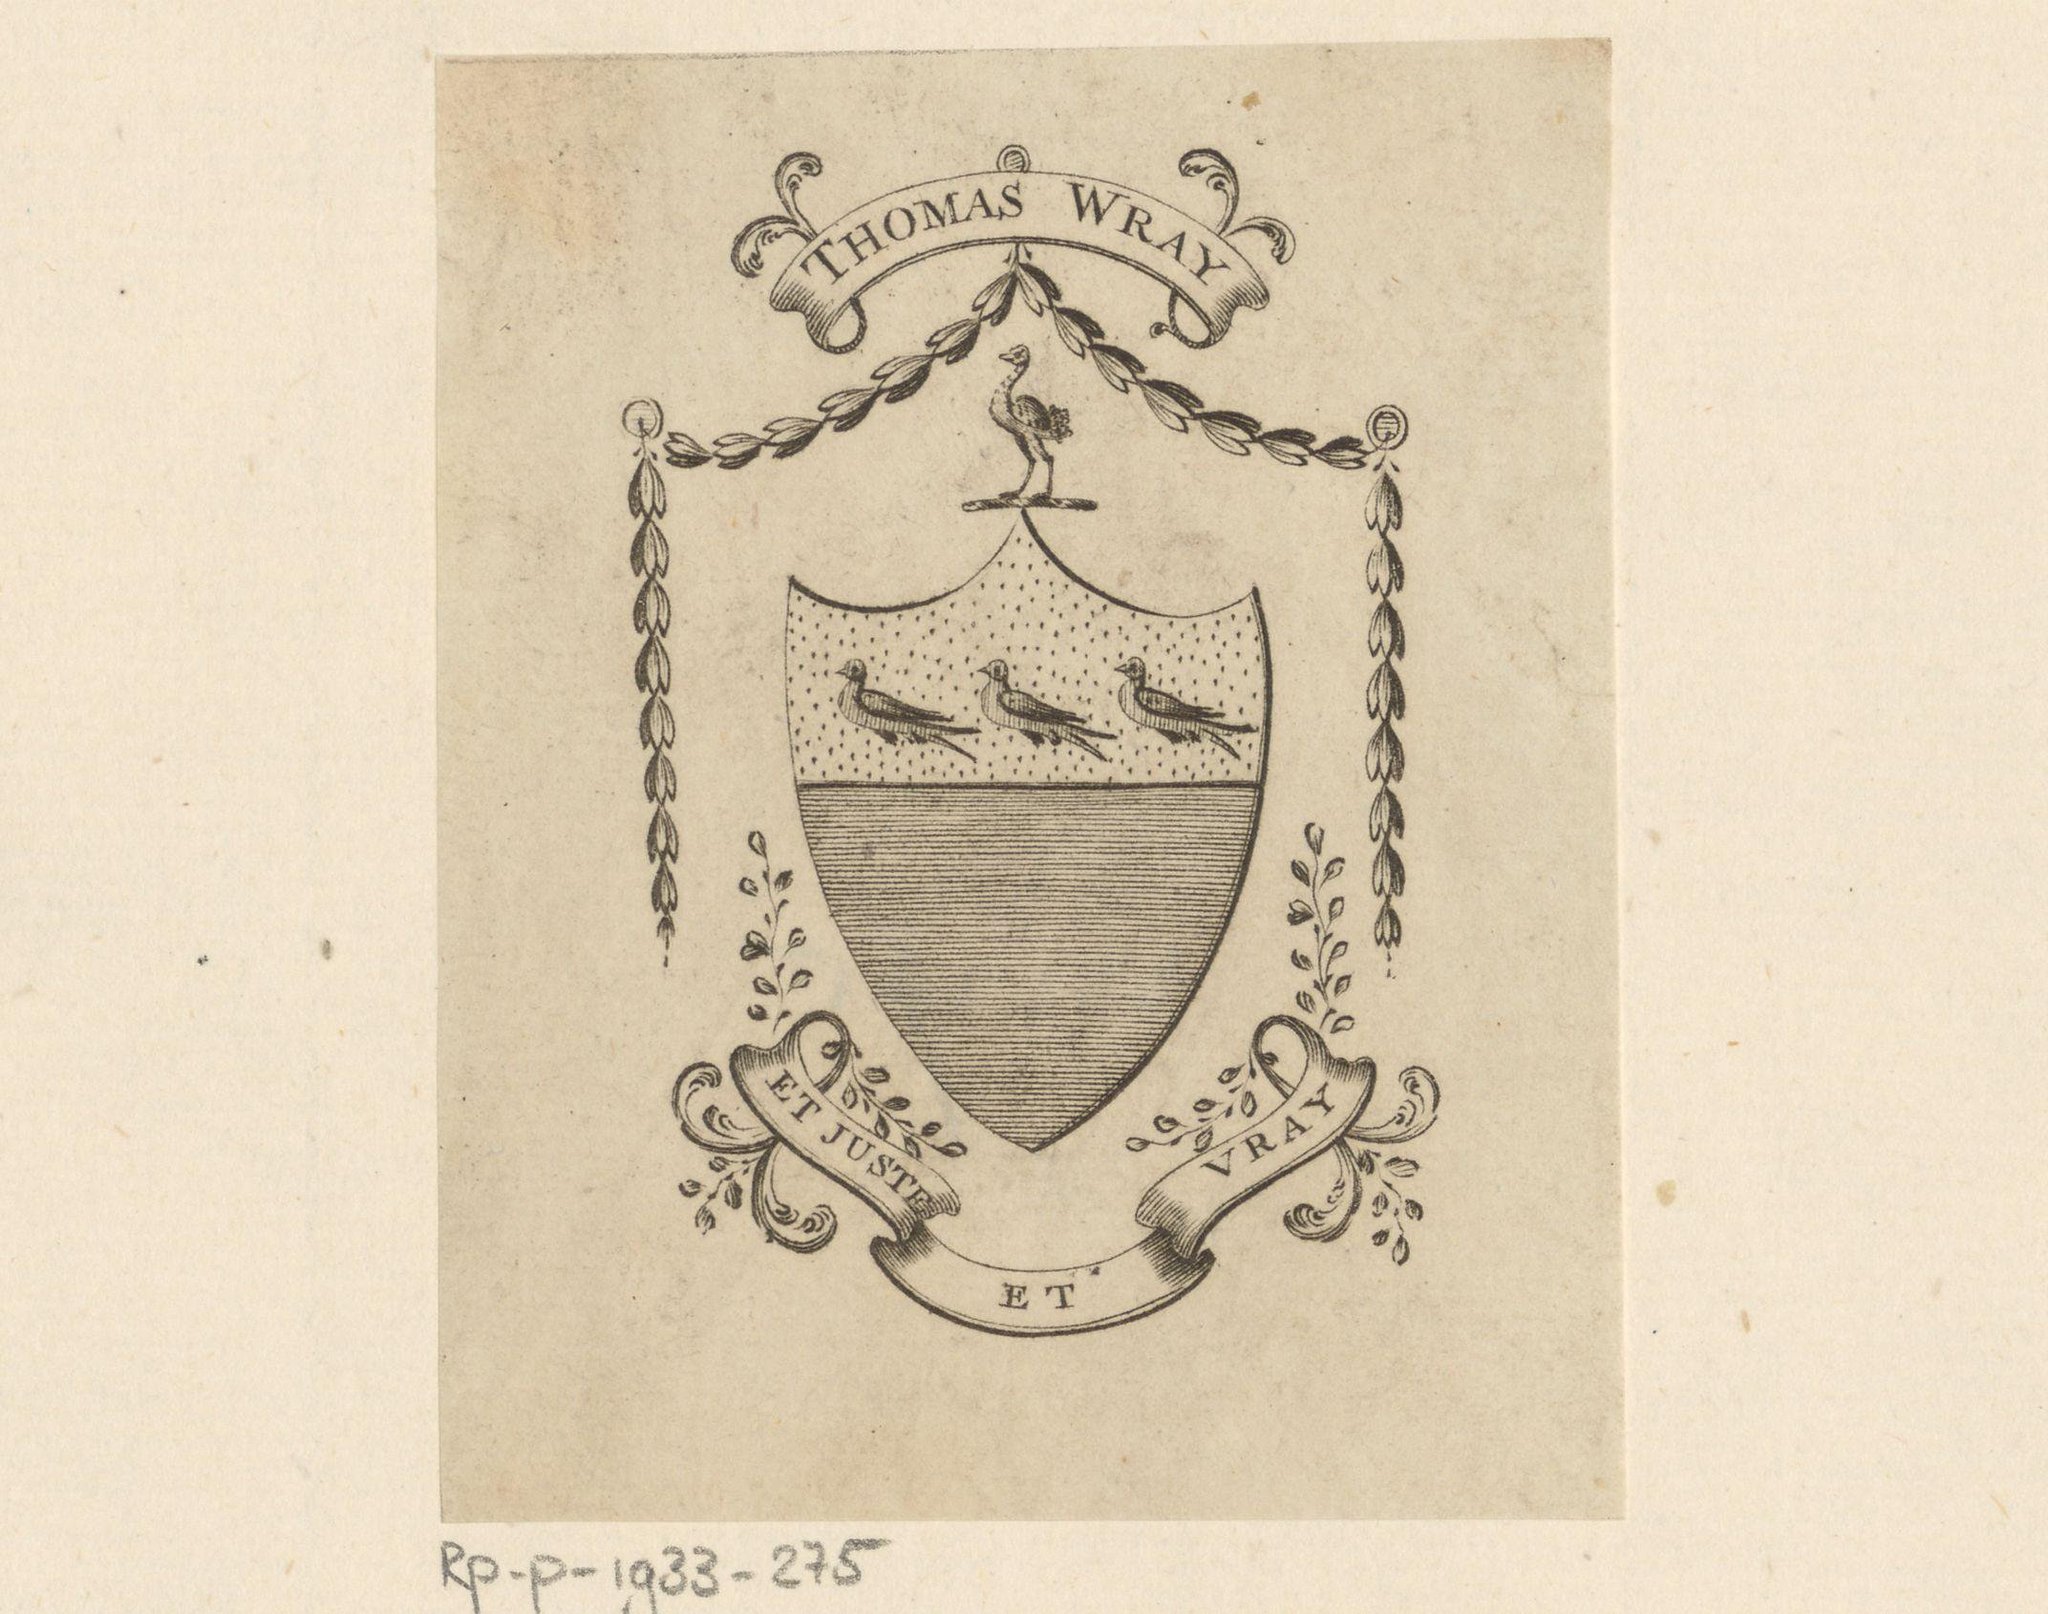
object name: bookplate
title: Ex libris van Thomas Wray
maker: Anonymous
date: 1750-1849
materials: paper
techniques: engraving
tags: armorial bearing, heraldry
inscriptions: collector's mark: Lugt 2760